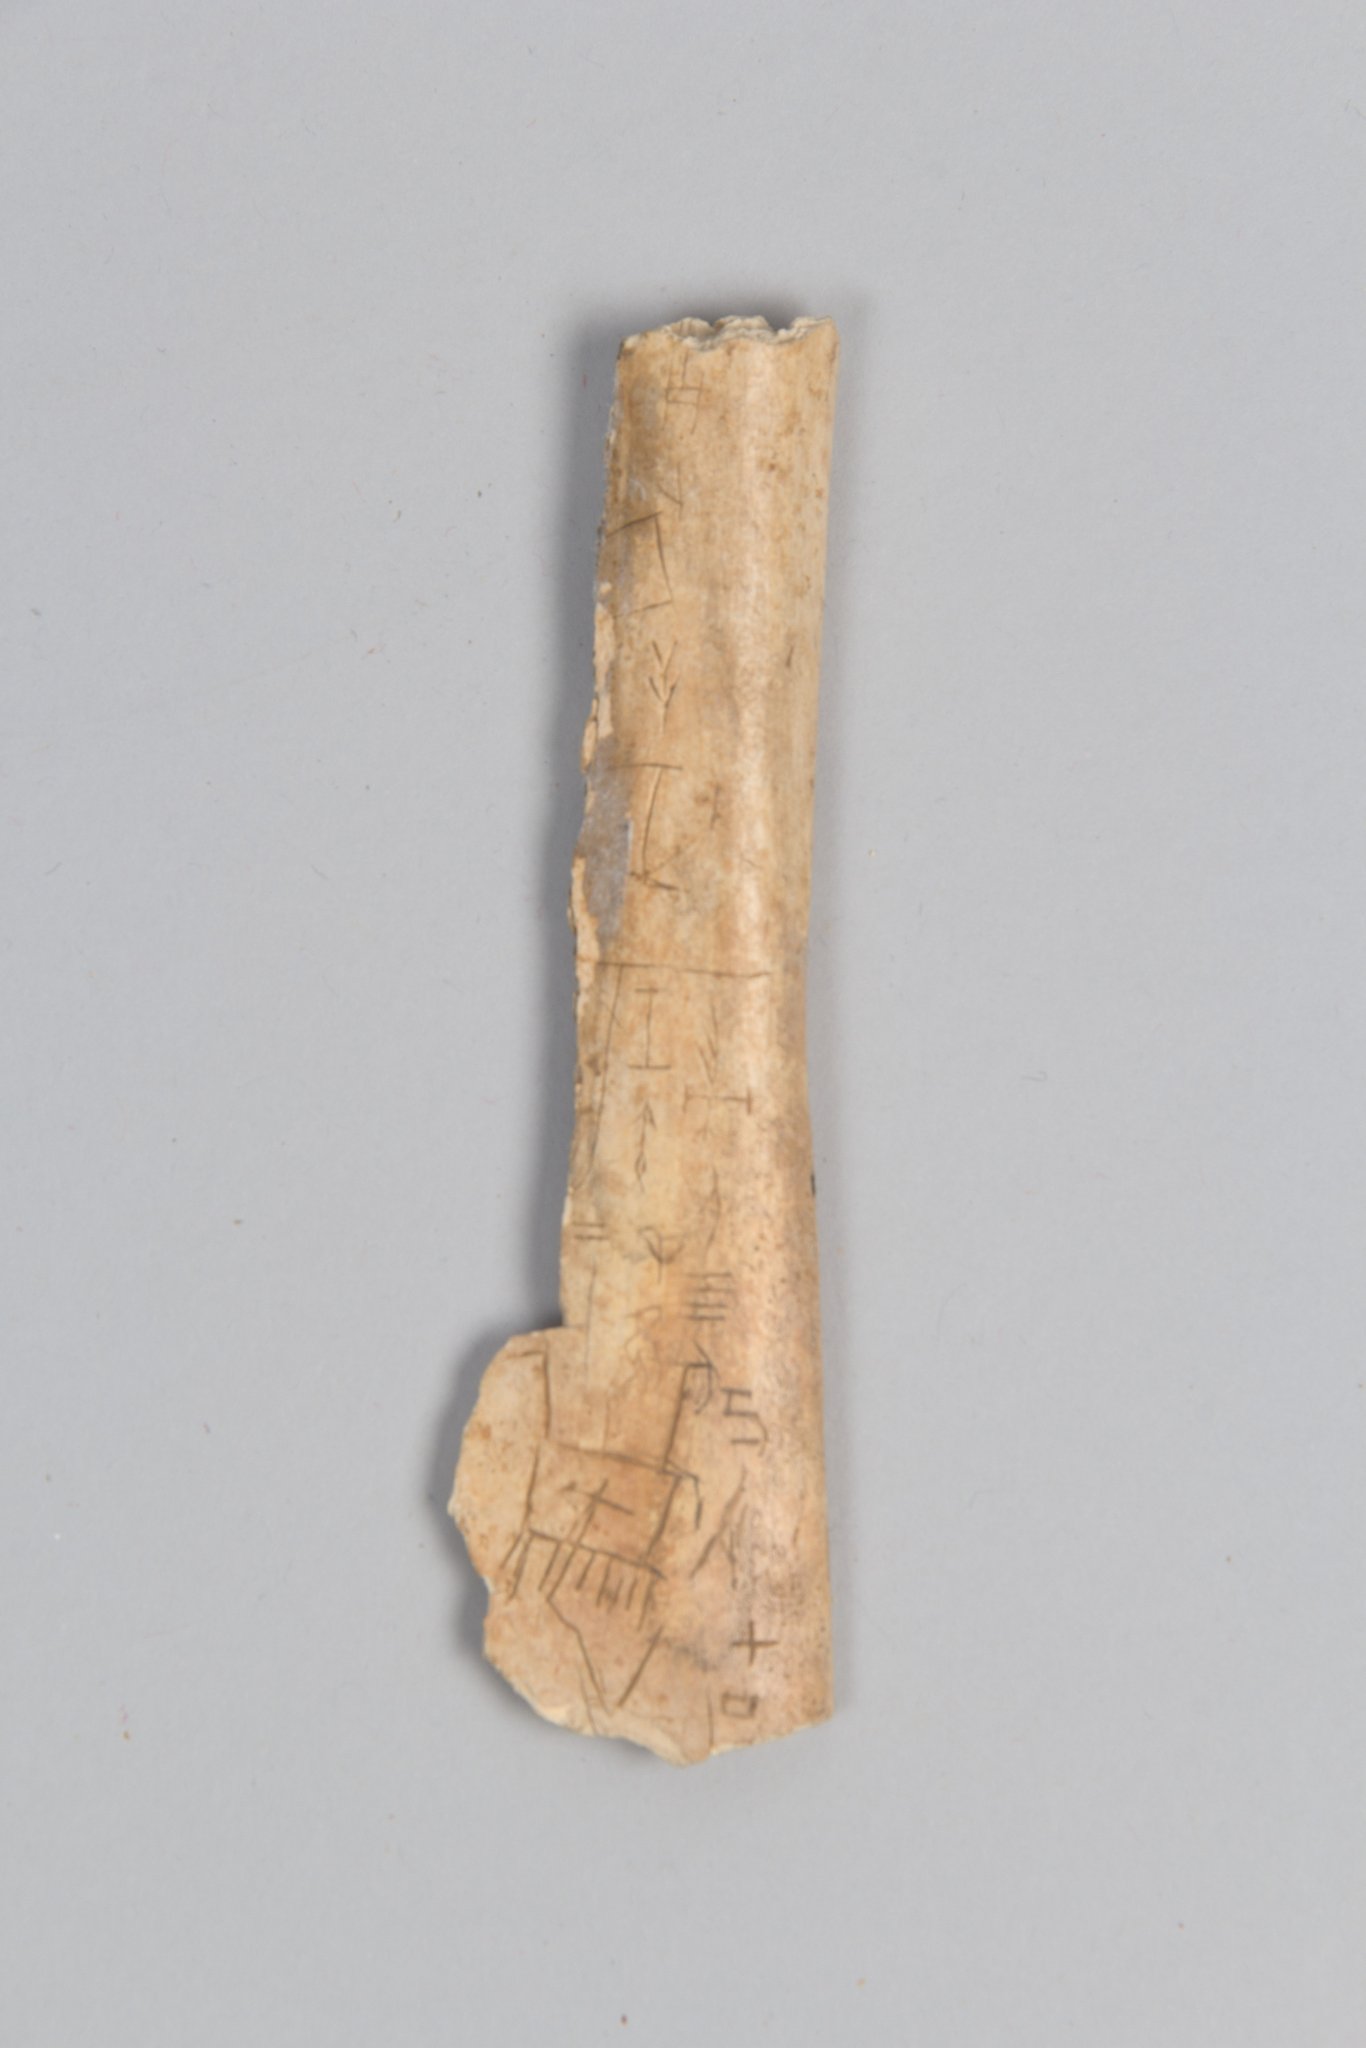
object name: oracle bone fragment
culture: chinese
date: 1610-1036 BCE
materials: bone